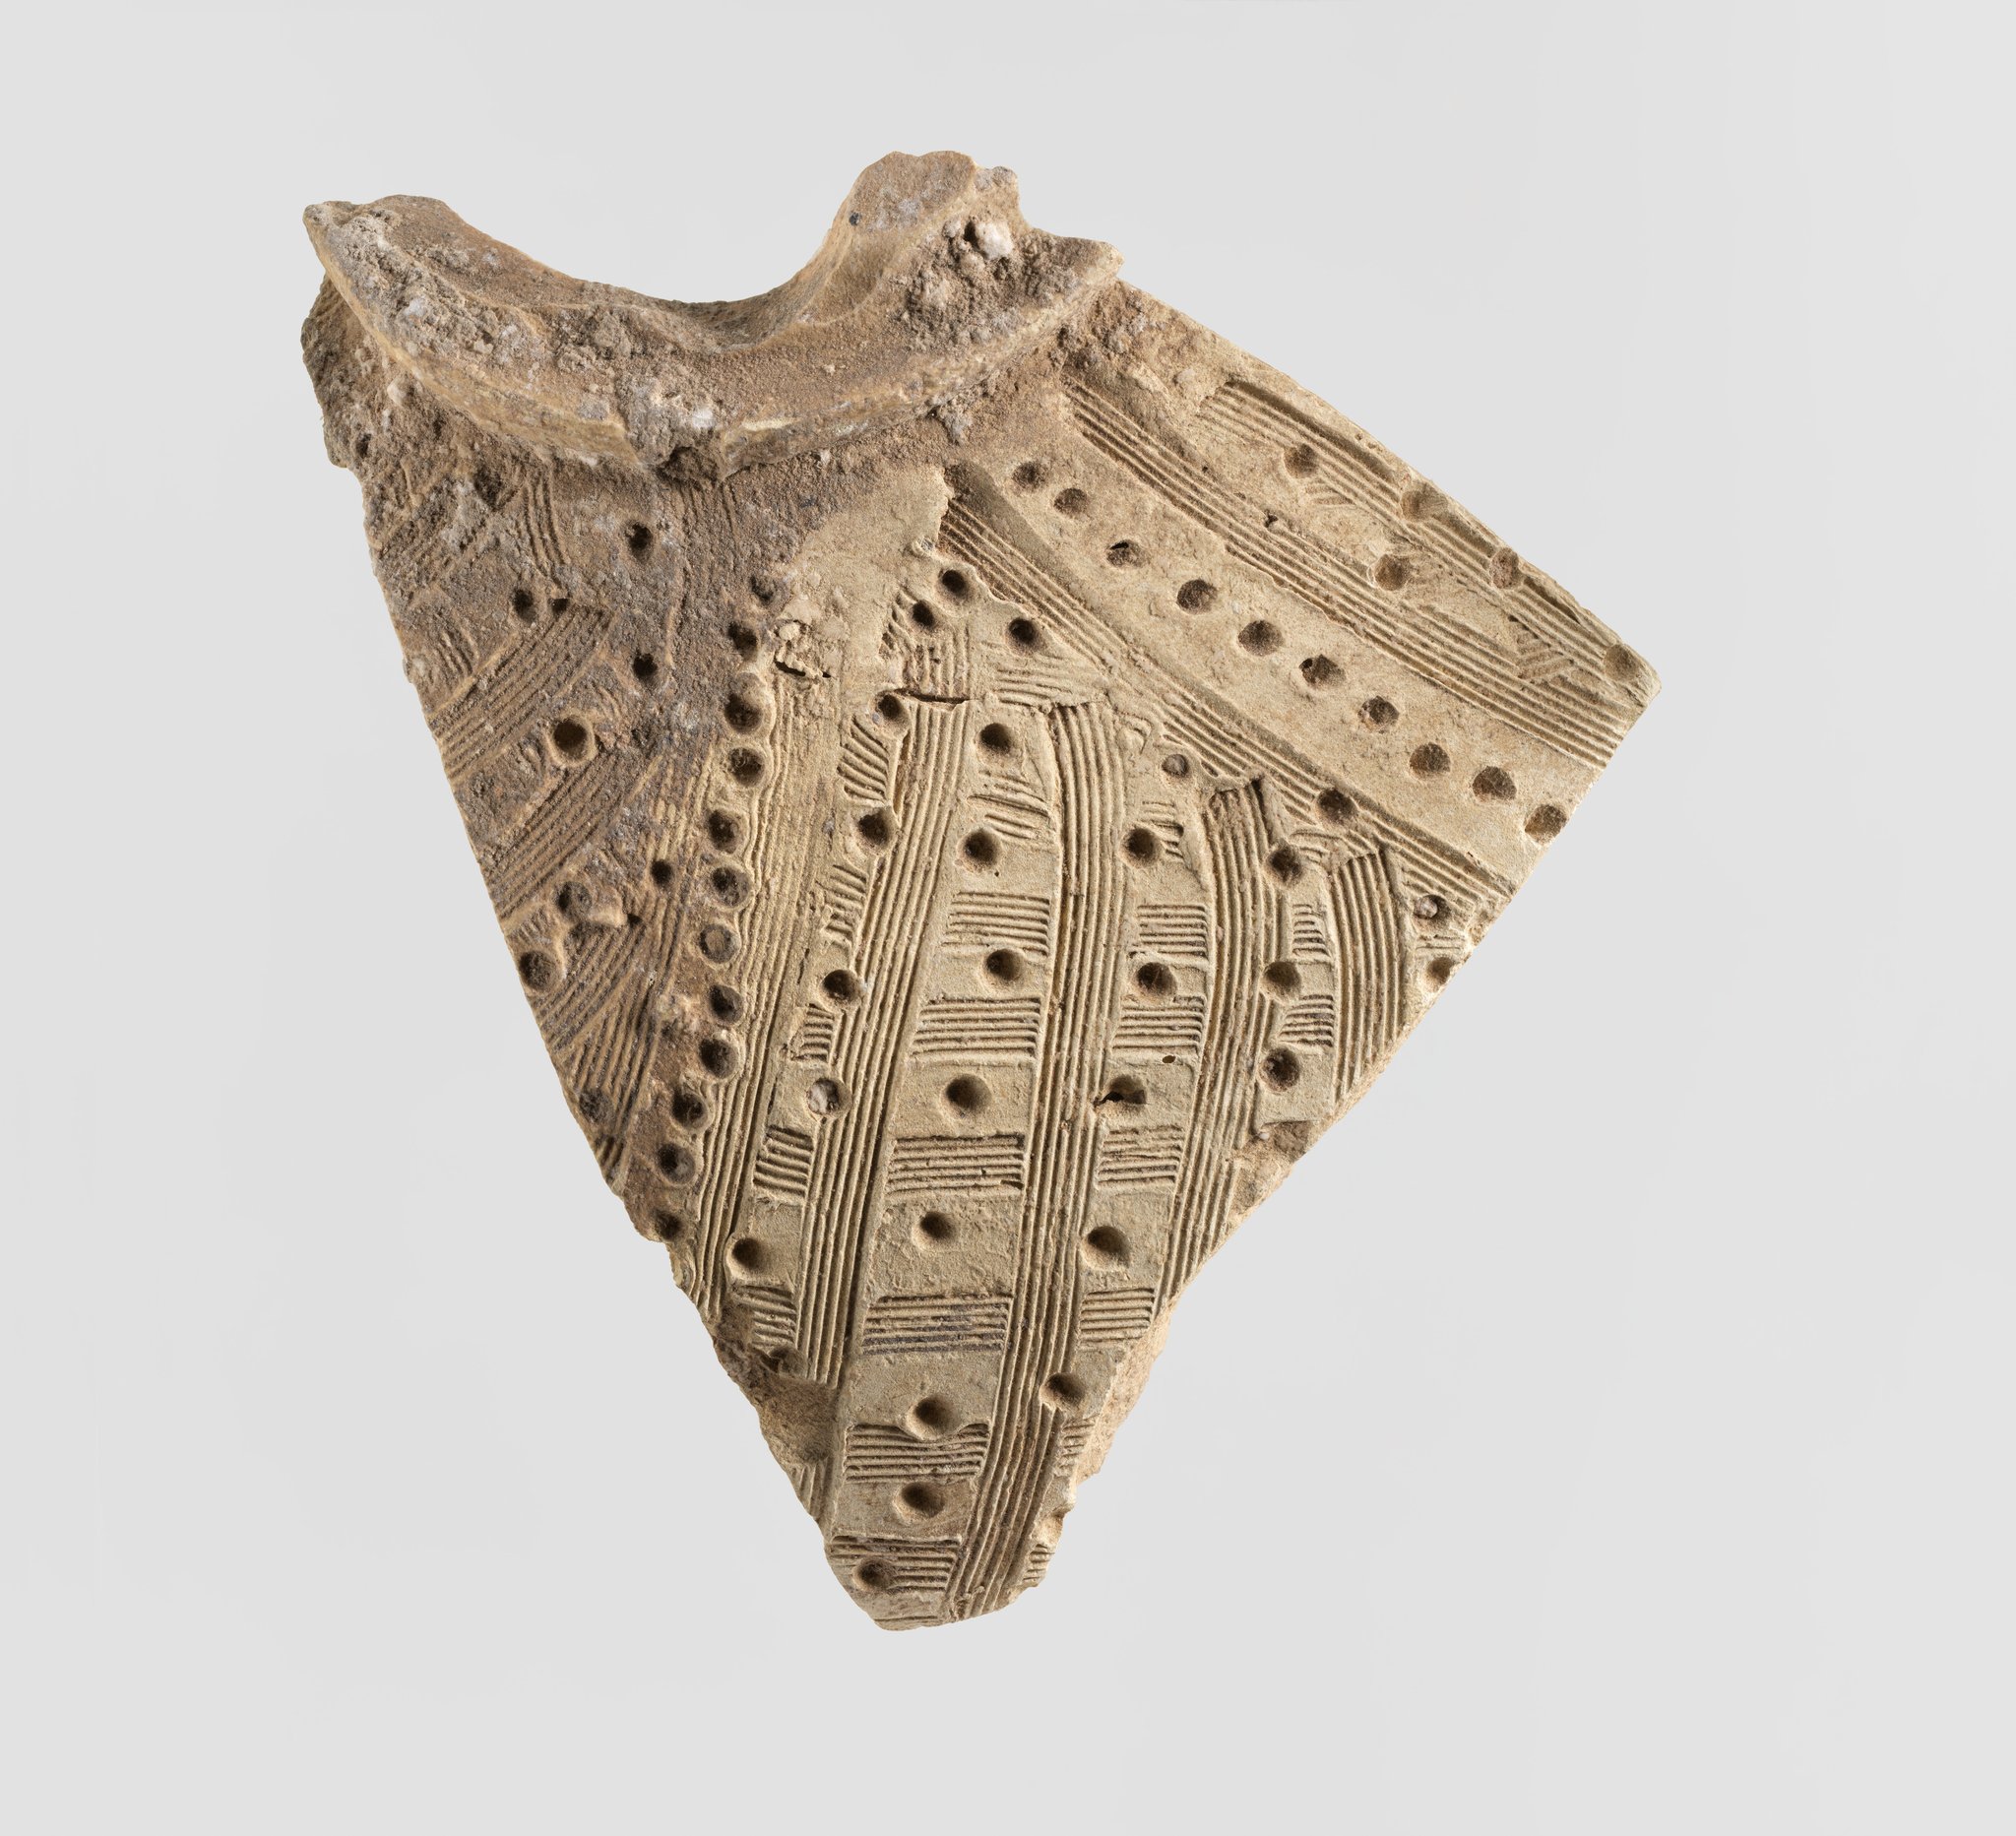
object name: sherd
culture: sasanian or islamic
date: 501-800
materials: ceramic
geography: mesopotamia